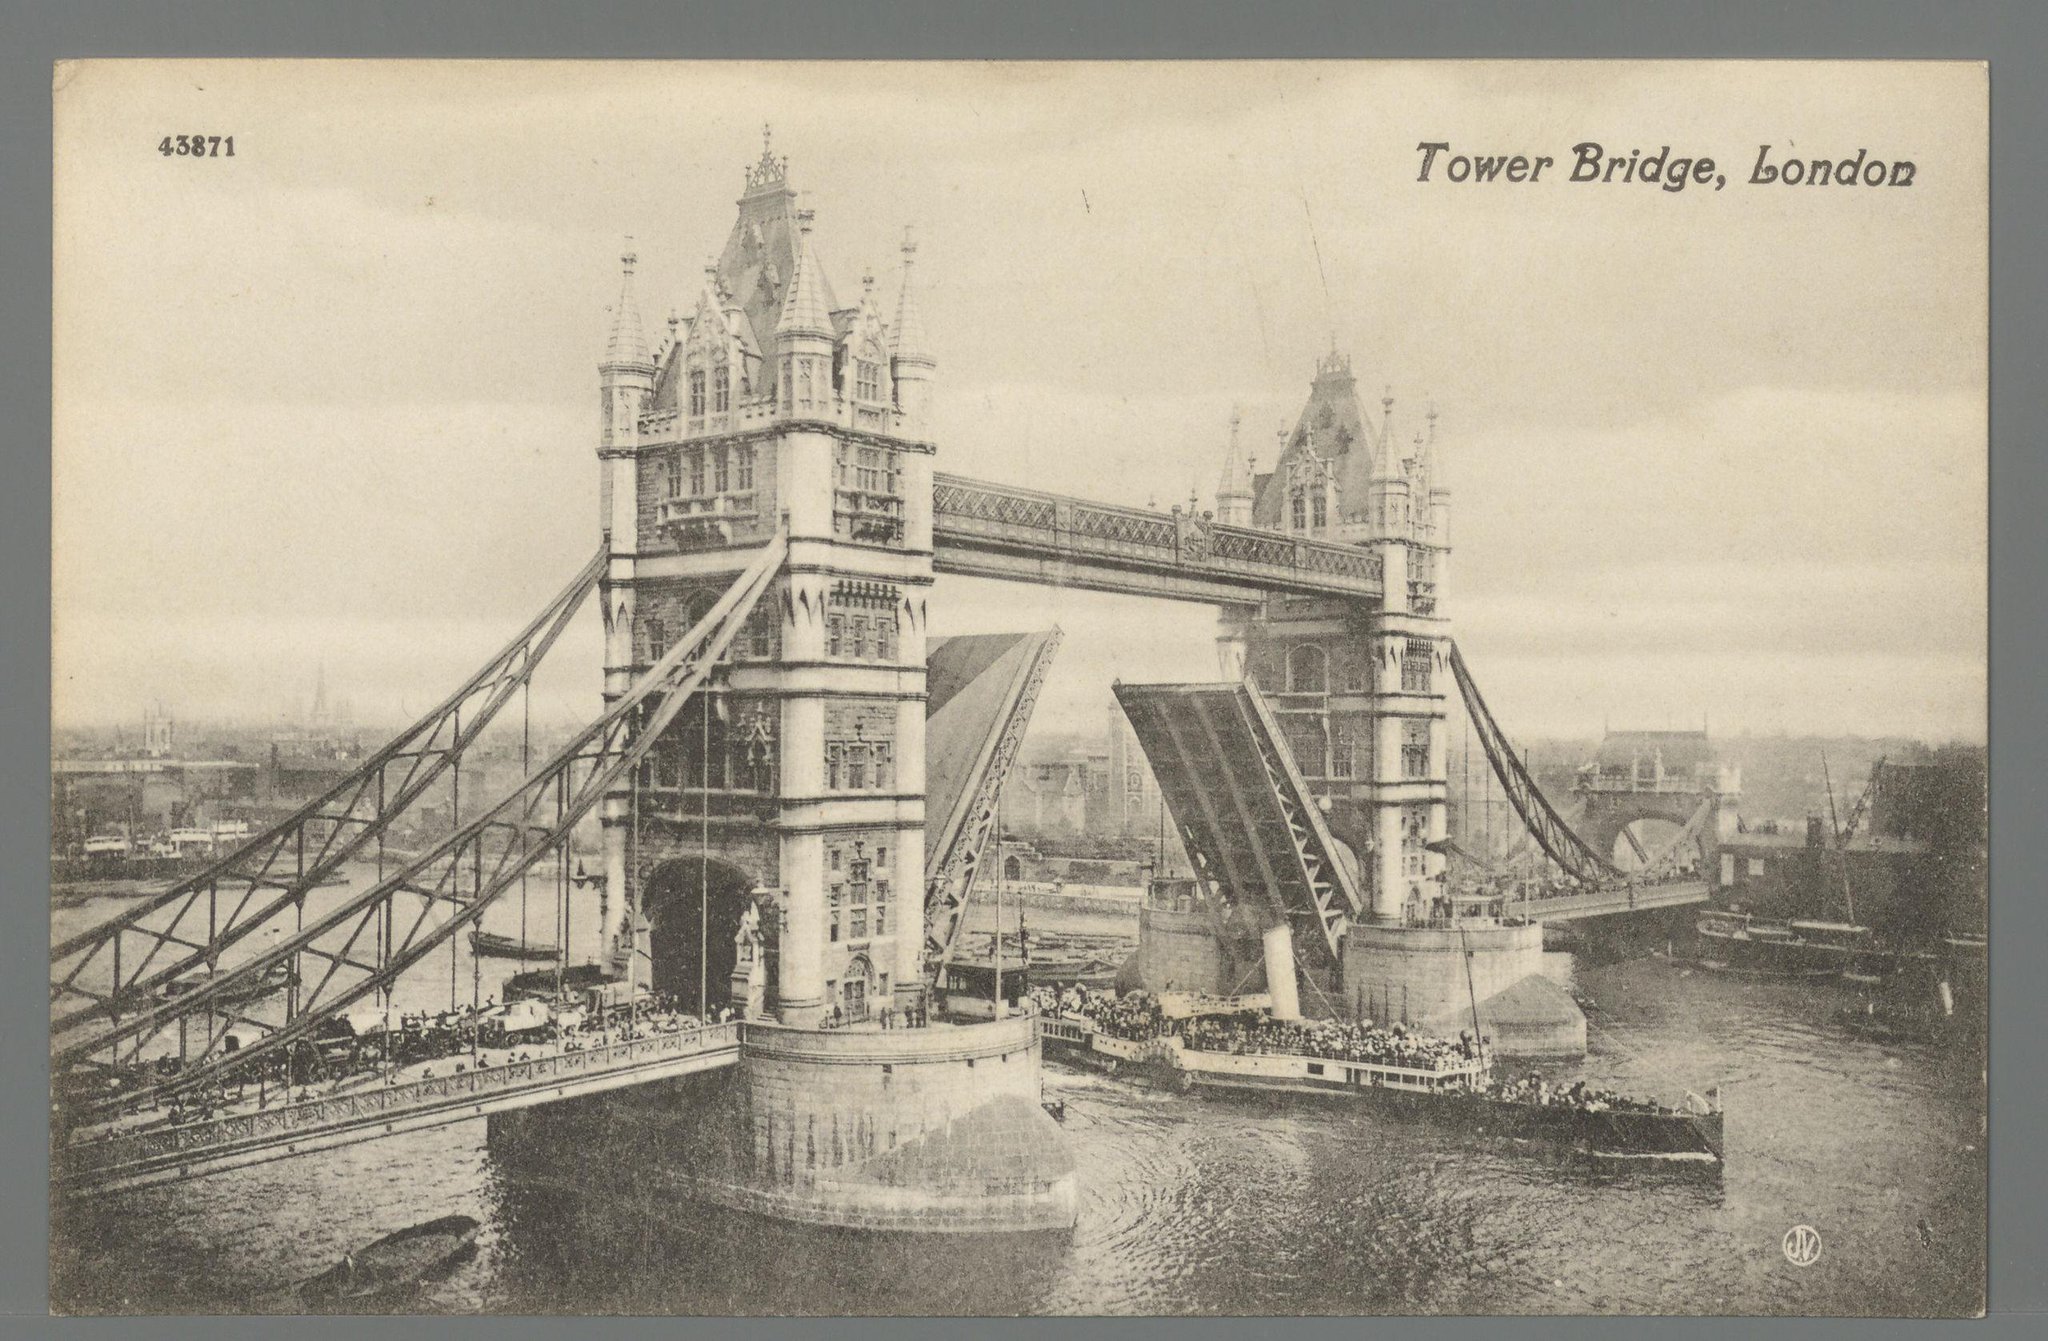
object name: ansichtkaart, prentbriefkaart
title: Valentine's Series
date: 1902-1930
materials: cardboard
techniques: photograph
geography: great britain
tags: canals, waters (in city), bridge in city across river, canal, etc., thames